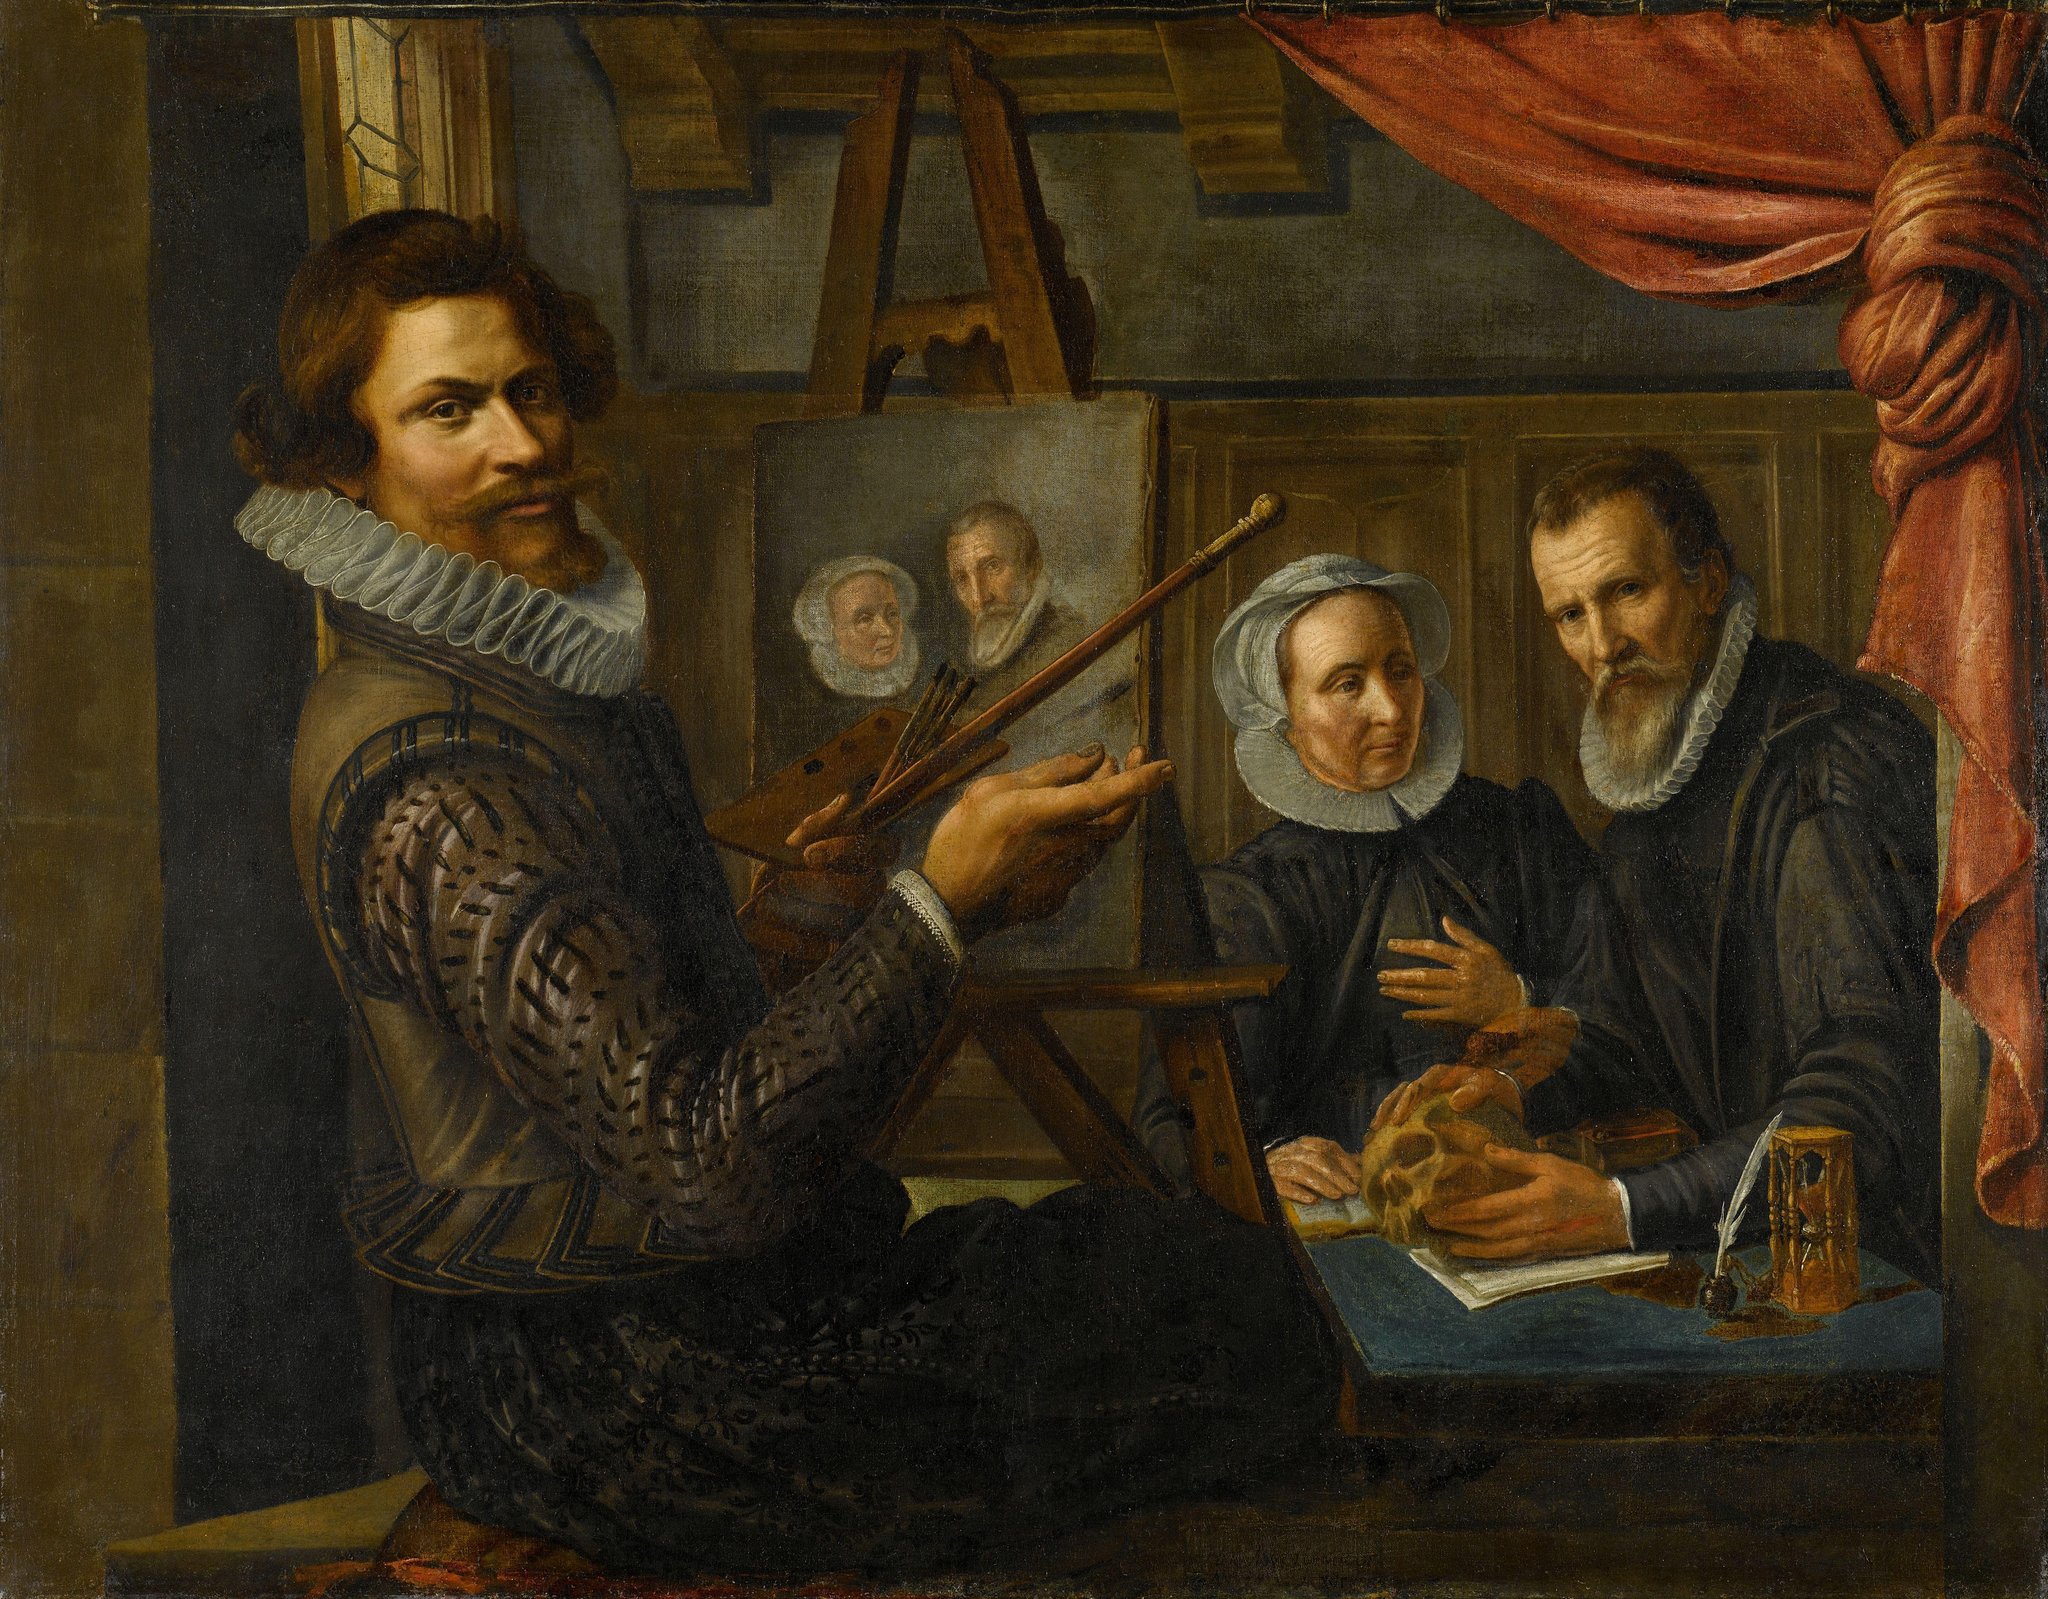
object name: painting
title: The Painter in his Studio Painting the Portrait of a Married Couple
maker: herman van vollenhoven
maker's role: painter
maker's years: 1575-1648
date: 1612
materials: canvas, oil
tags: painter, herman van vollenhoven, painter working from live model, portrait, self-portrait of artist, picture, painting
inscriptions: signature and date, bottom centre: ‘H. Vollenhove Anº 1612 in Wtre’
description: De schilder in zijn werkplaats bezig met het portretteren van een echtpaar. De schilder zit achter het schilderij op de ezel met palet, penselen en schildersstok in de hand. Rechts poseert het echtpaar zittend aan een tafel waarop een schedel, brieven en een zandloper staan.